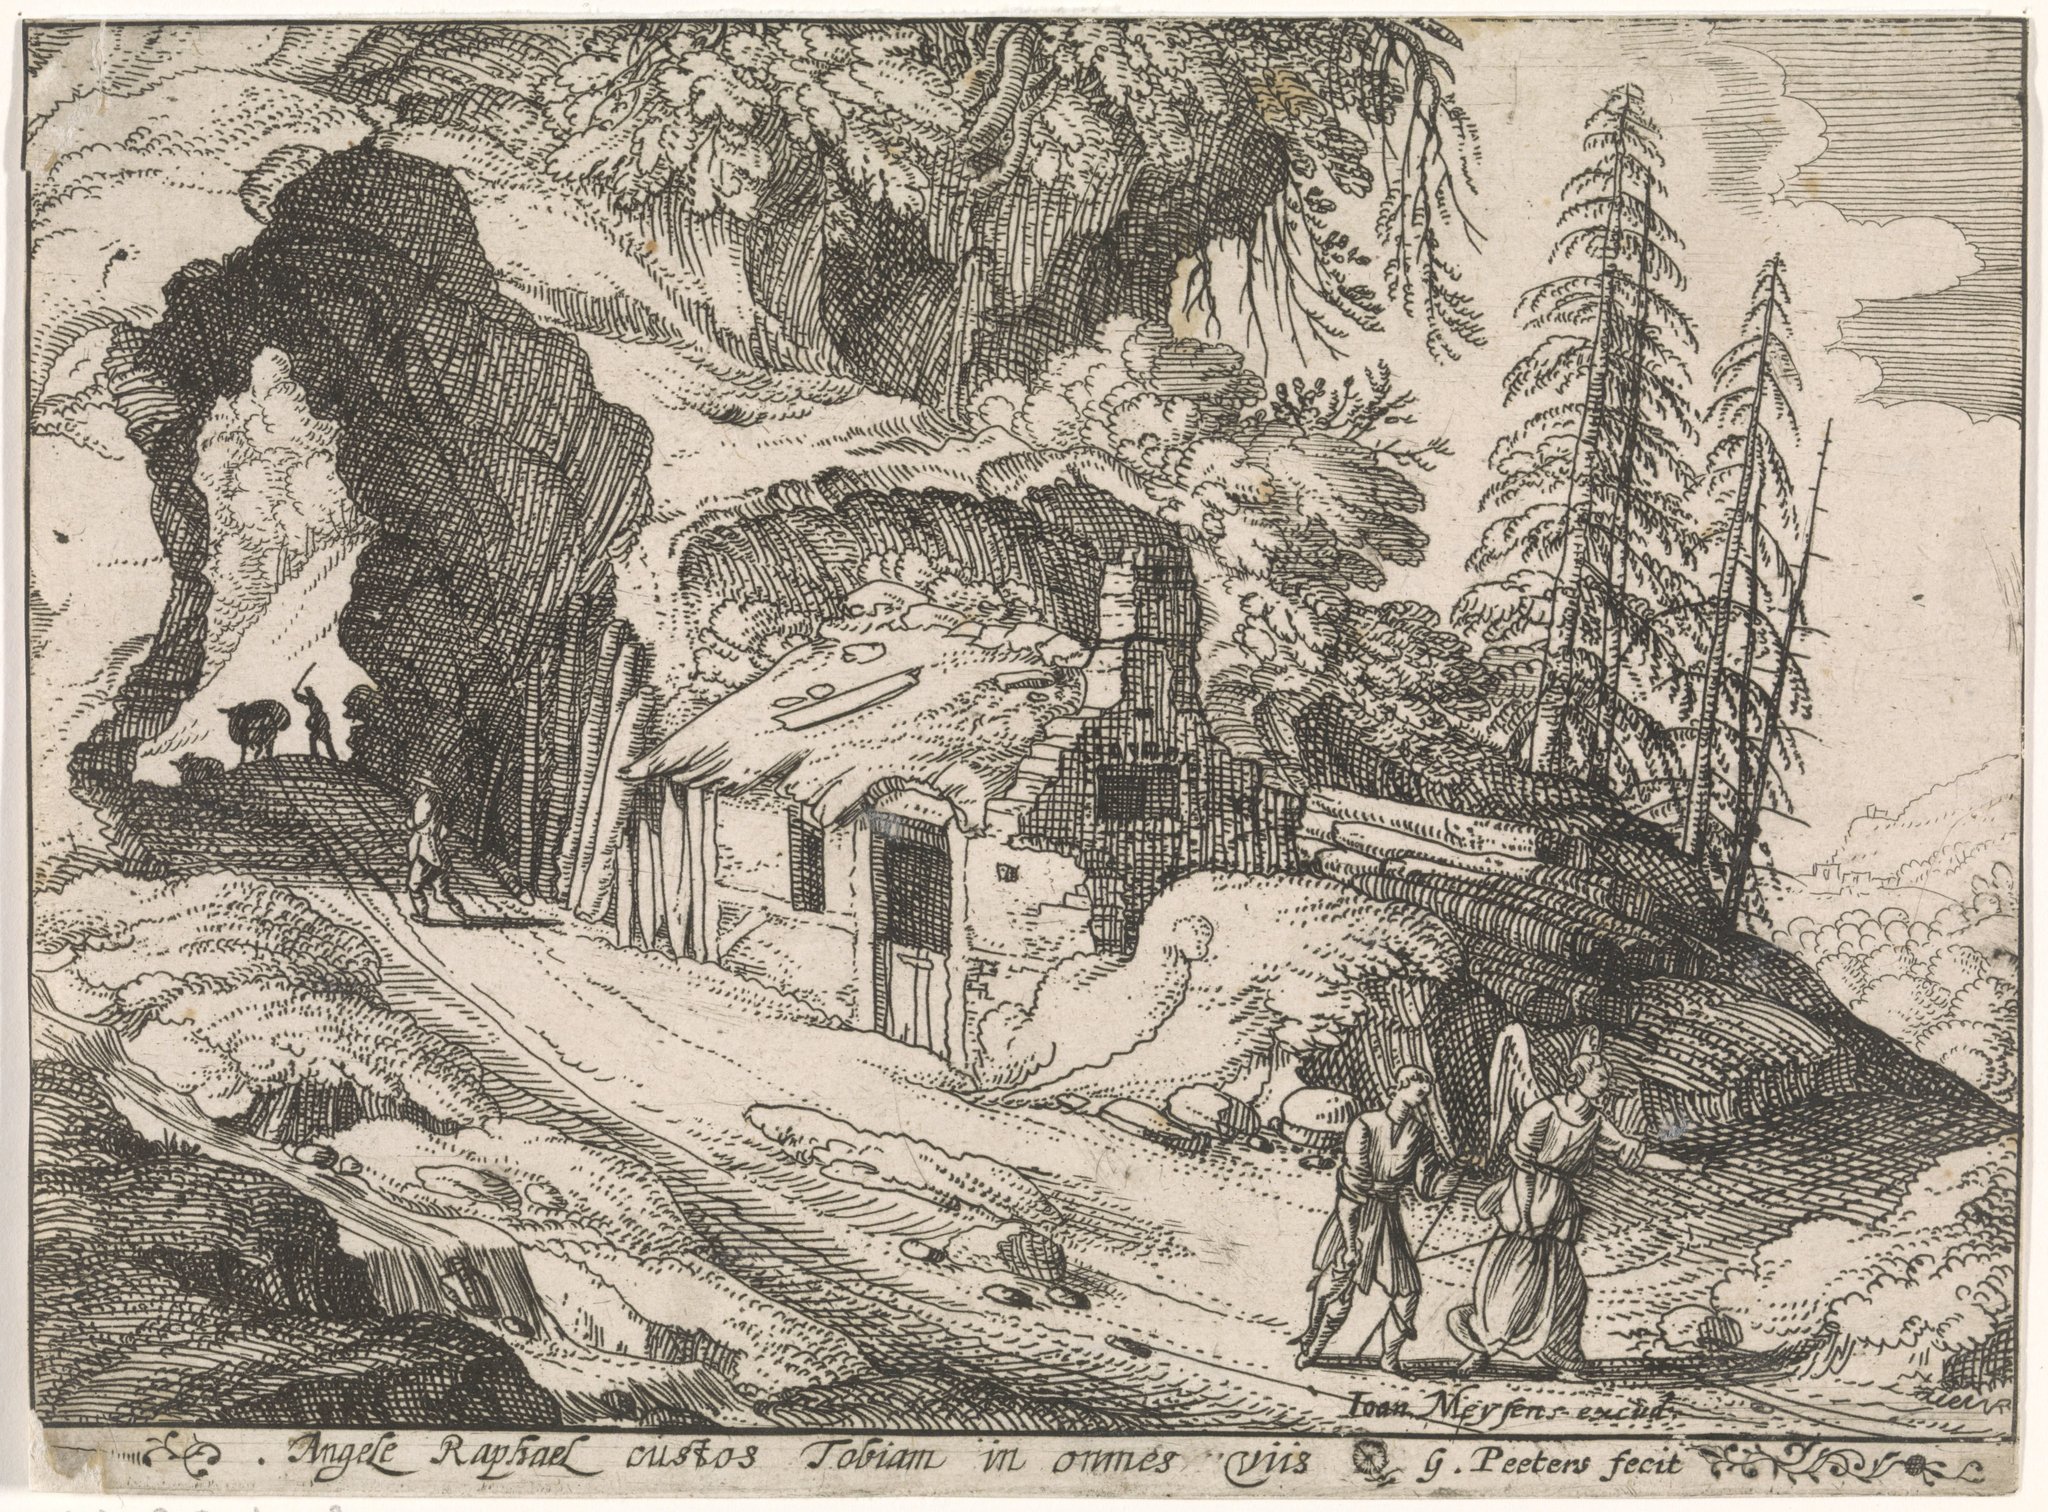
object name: print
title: Landschap met Tobias en aartsengel Rafaël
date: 1634-1653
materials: paper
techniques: etching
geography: antwerp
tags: tobias and the angel raphael travelling, accompanied by tobias' dog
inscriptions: collector's mark: Lugt 1293, collector's mark: Lugt 2228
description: Landschap met een hut langs een pad gelegen. Rechts op de voorgrond Tobias en de aartsengel Rafaël. Op de achtergrond tussen een rotsspleet twee herders met vee. In de marge een onderschrift in het Latijn.